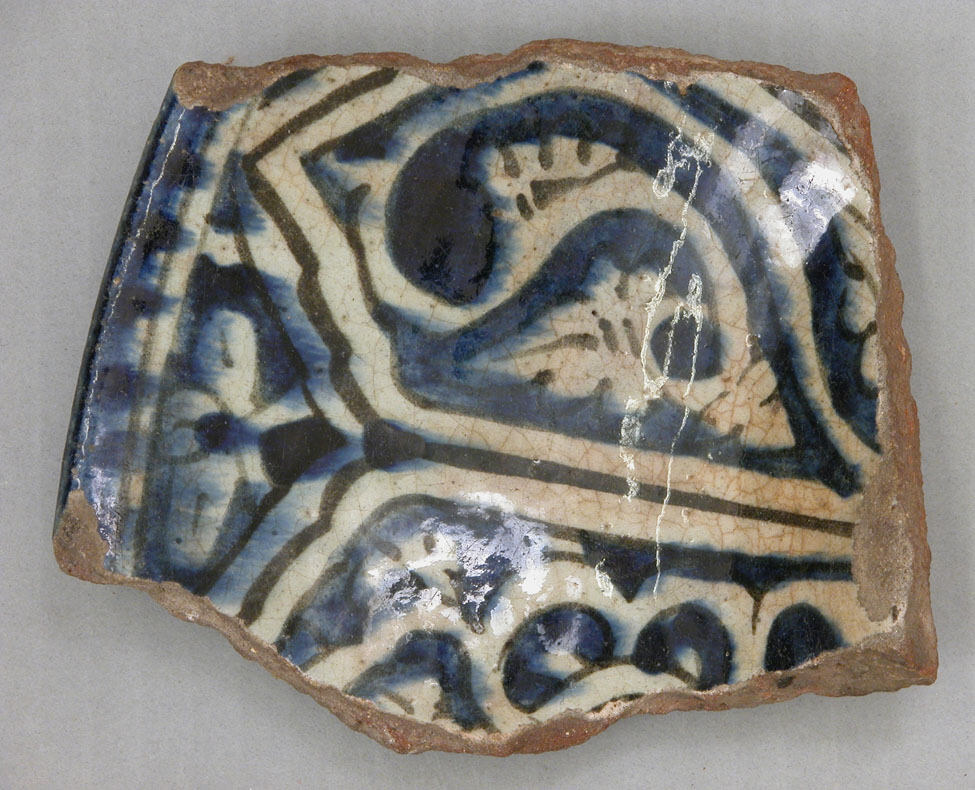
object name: fragment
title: Ceramic Fragment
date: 1401-1500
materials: glaze, stonepaste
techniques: painting, polychrome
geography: egypt